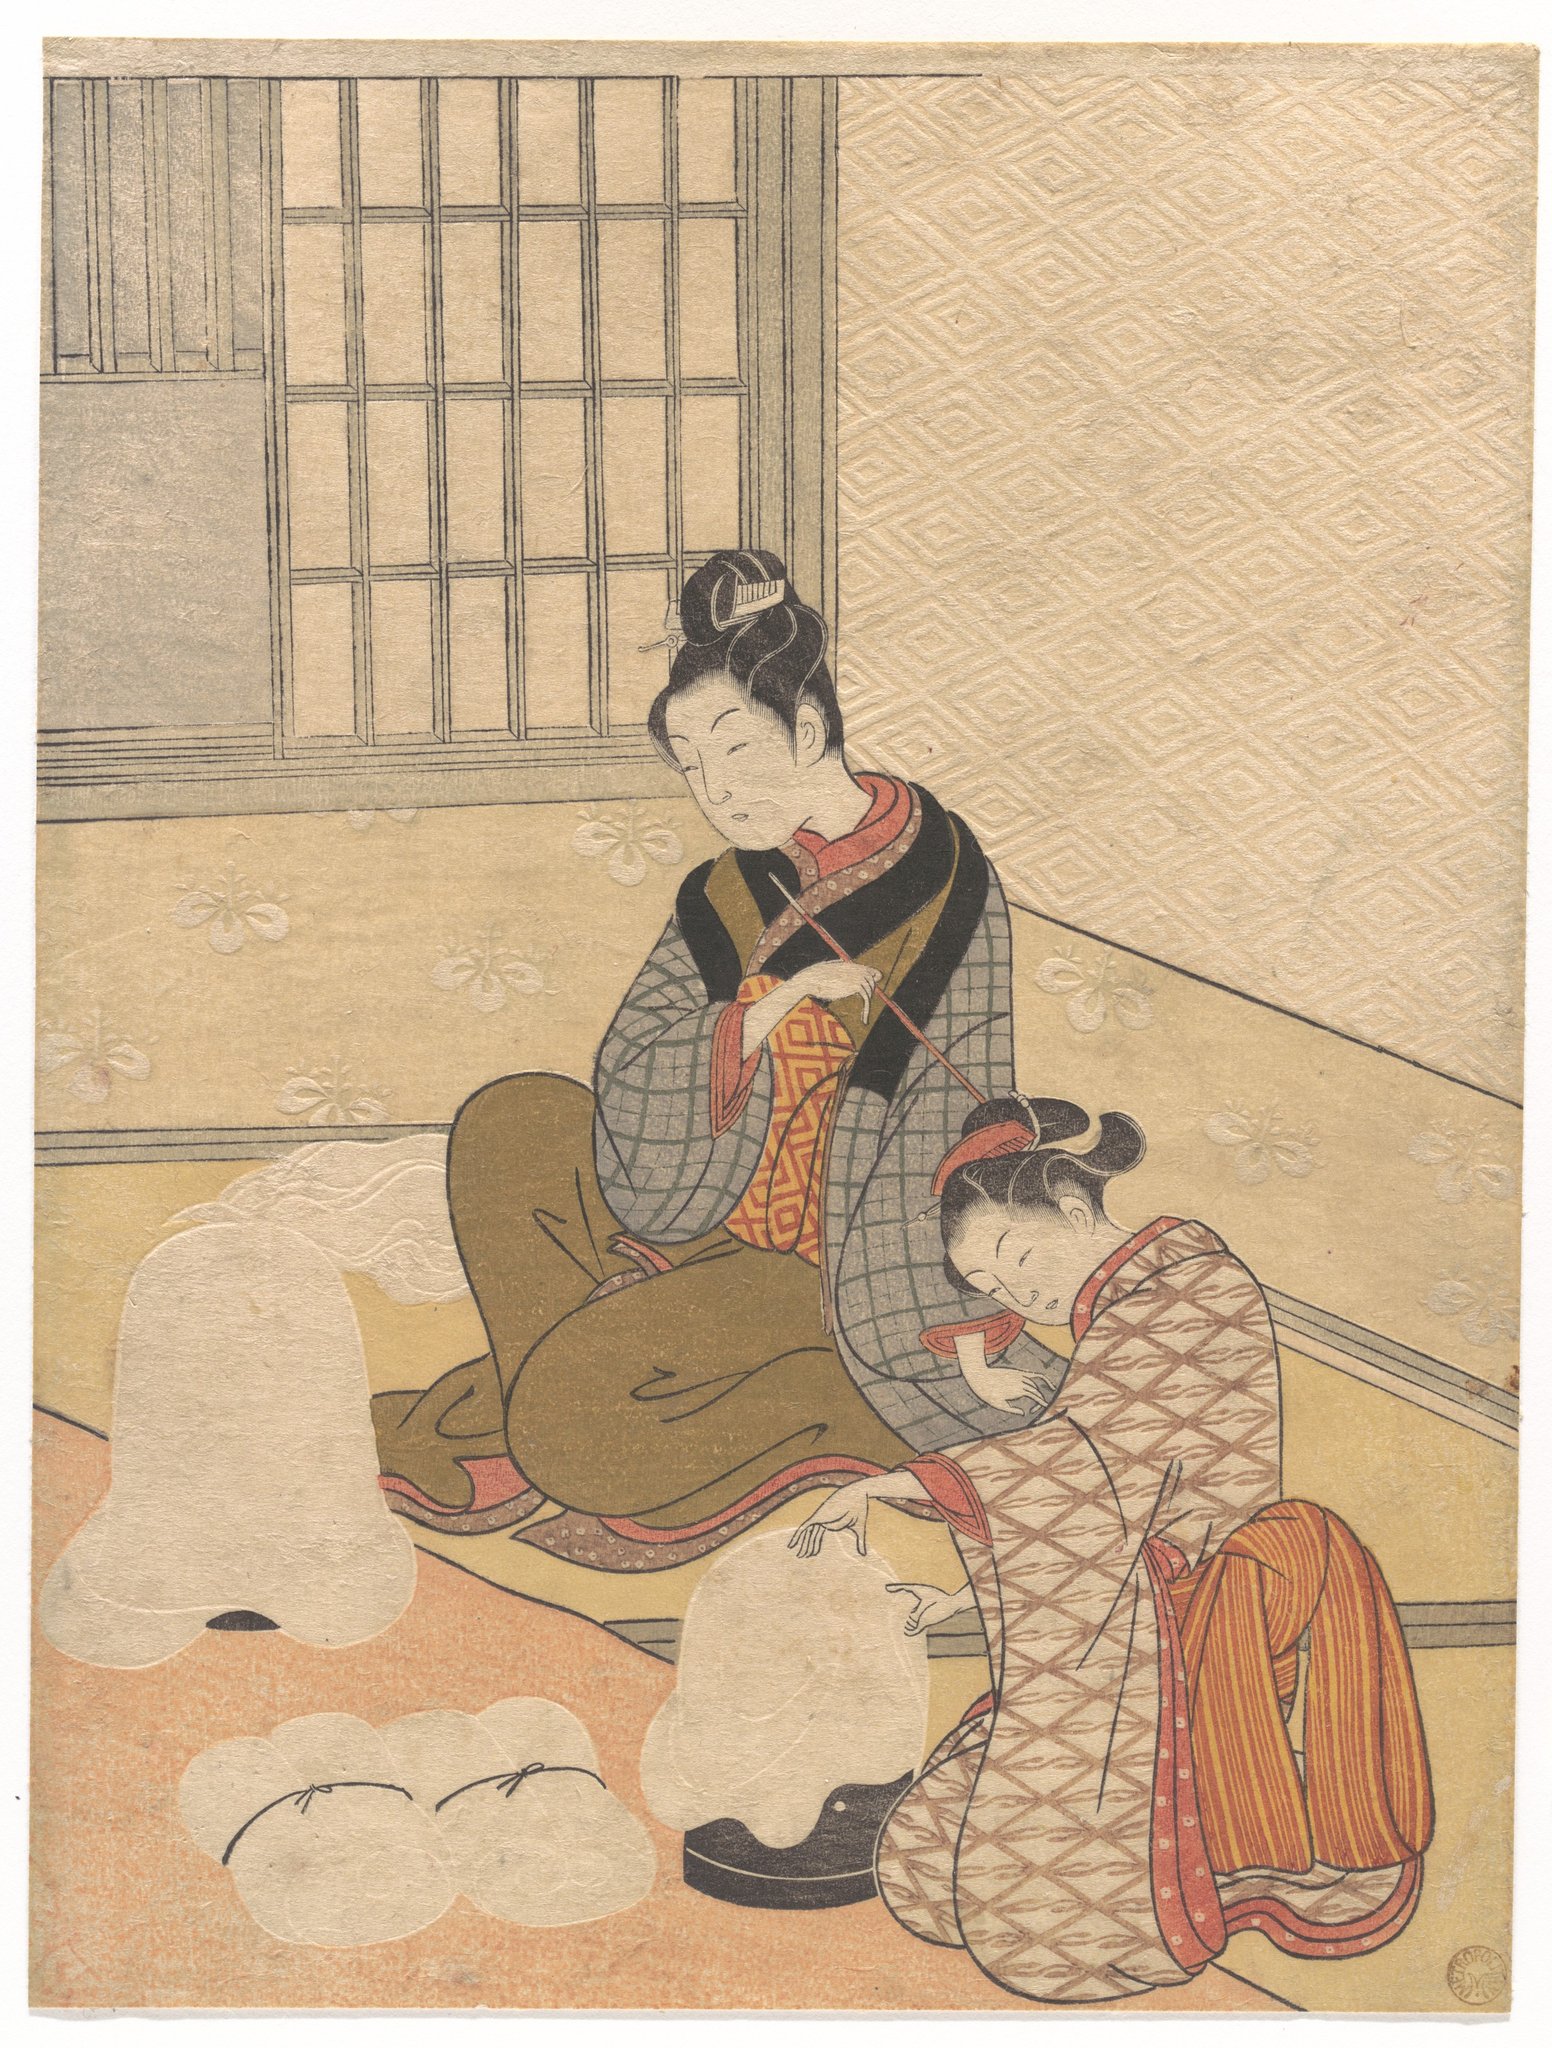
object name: print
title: Evening Snow on the Nurioke, from the series Eight Parlor Views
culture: japanese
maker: suzuki harunobu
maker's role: artist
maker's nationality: japanese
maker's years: 1725-1770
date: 1766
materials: ink, paper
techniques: woodblock print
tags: interiors,women,working